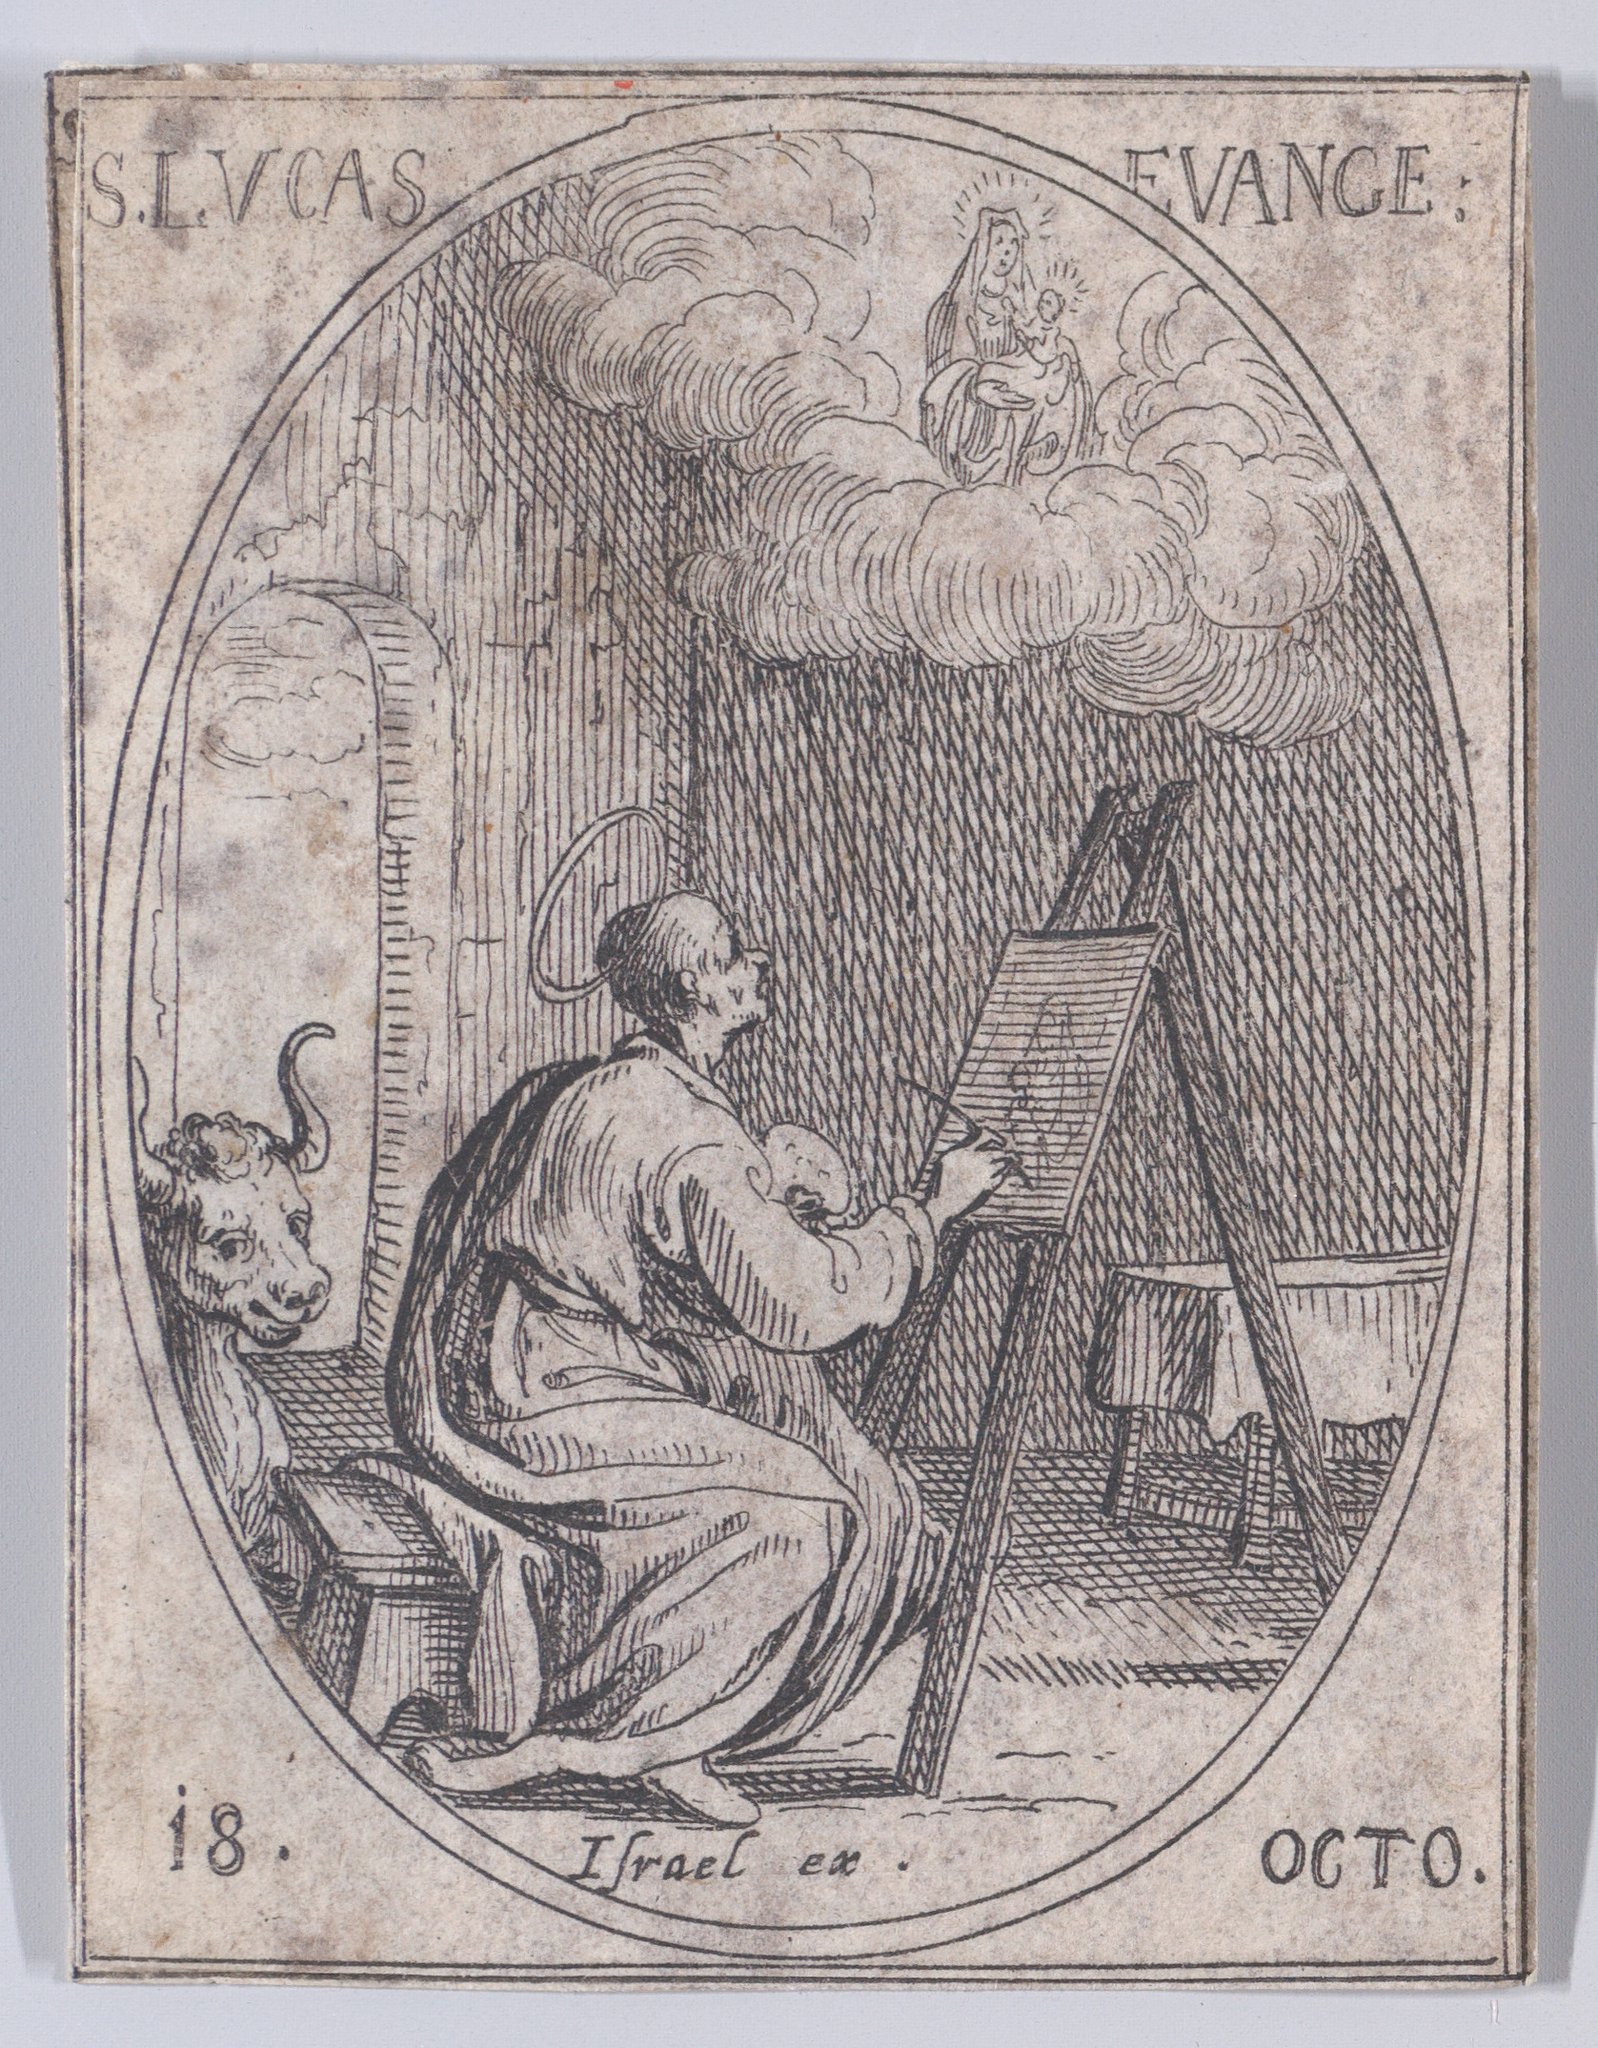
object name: print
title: S. Luc, évangéliste (St. Luke, Evangelist), October 18th, from "Les Images De Tous Les Saincts et Saintes de L'Année" (Images of All of the Saints and Religious Events of the Year)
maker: jacques callot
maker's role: artist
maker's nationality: french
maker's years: 1592-1635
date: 1636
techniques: etching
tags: painting,men,saint luke